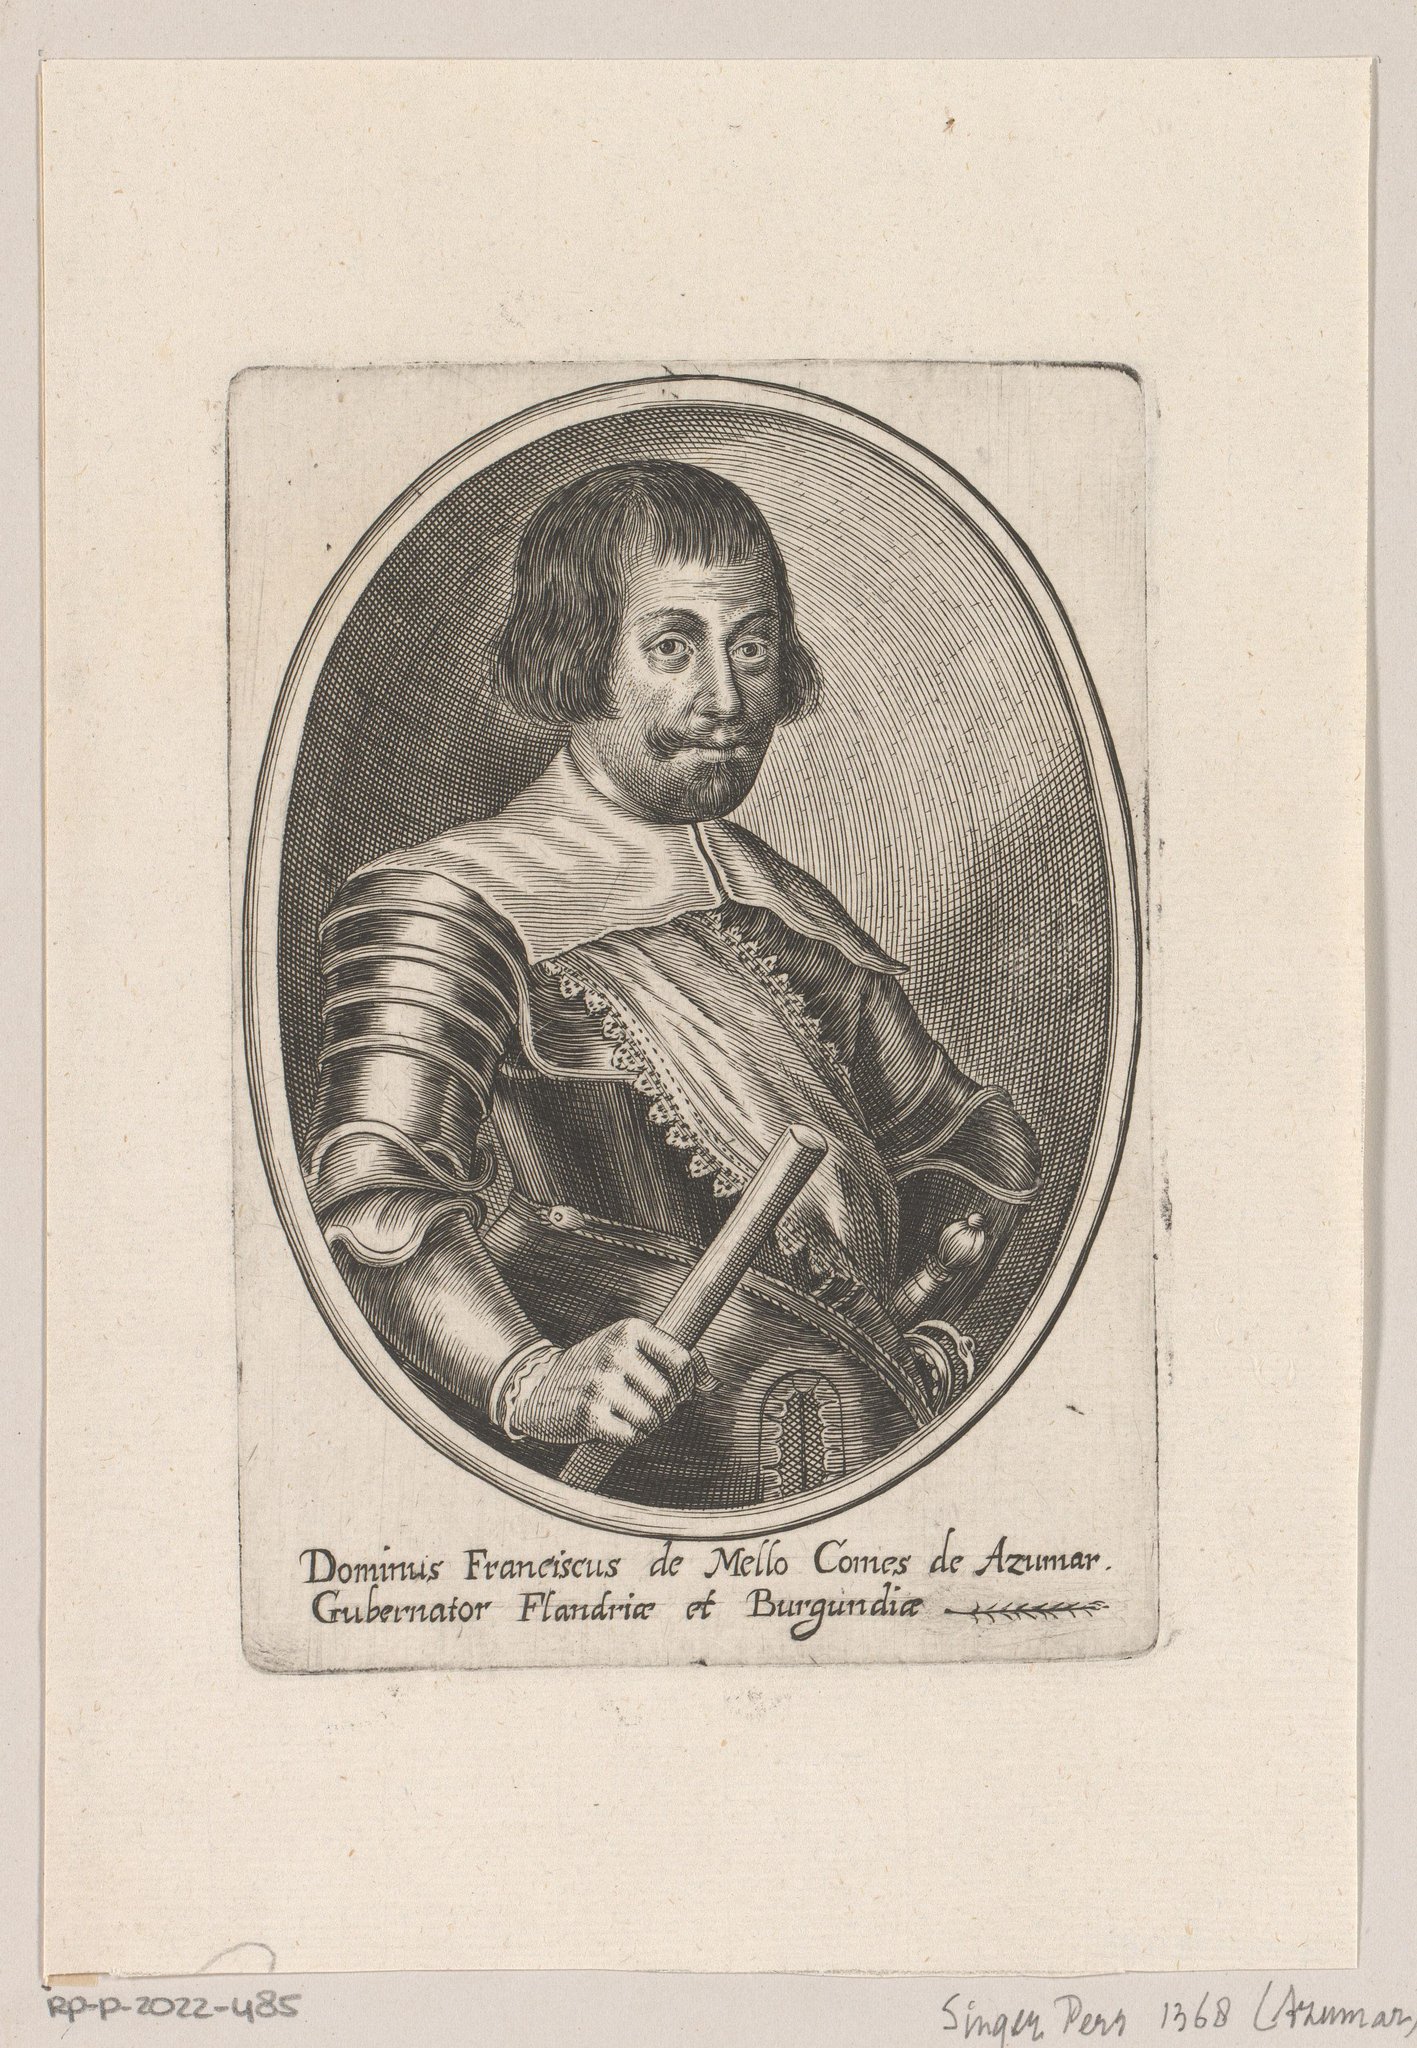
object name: print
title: Portret van Francisco de Melo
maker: Anonymous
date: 1650-1750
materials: paper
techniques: engraving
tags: historical persons